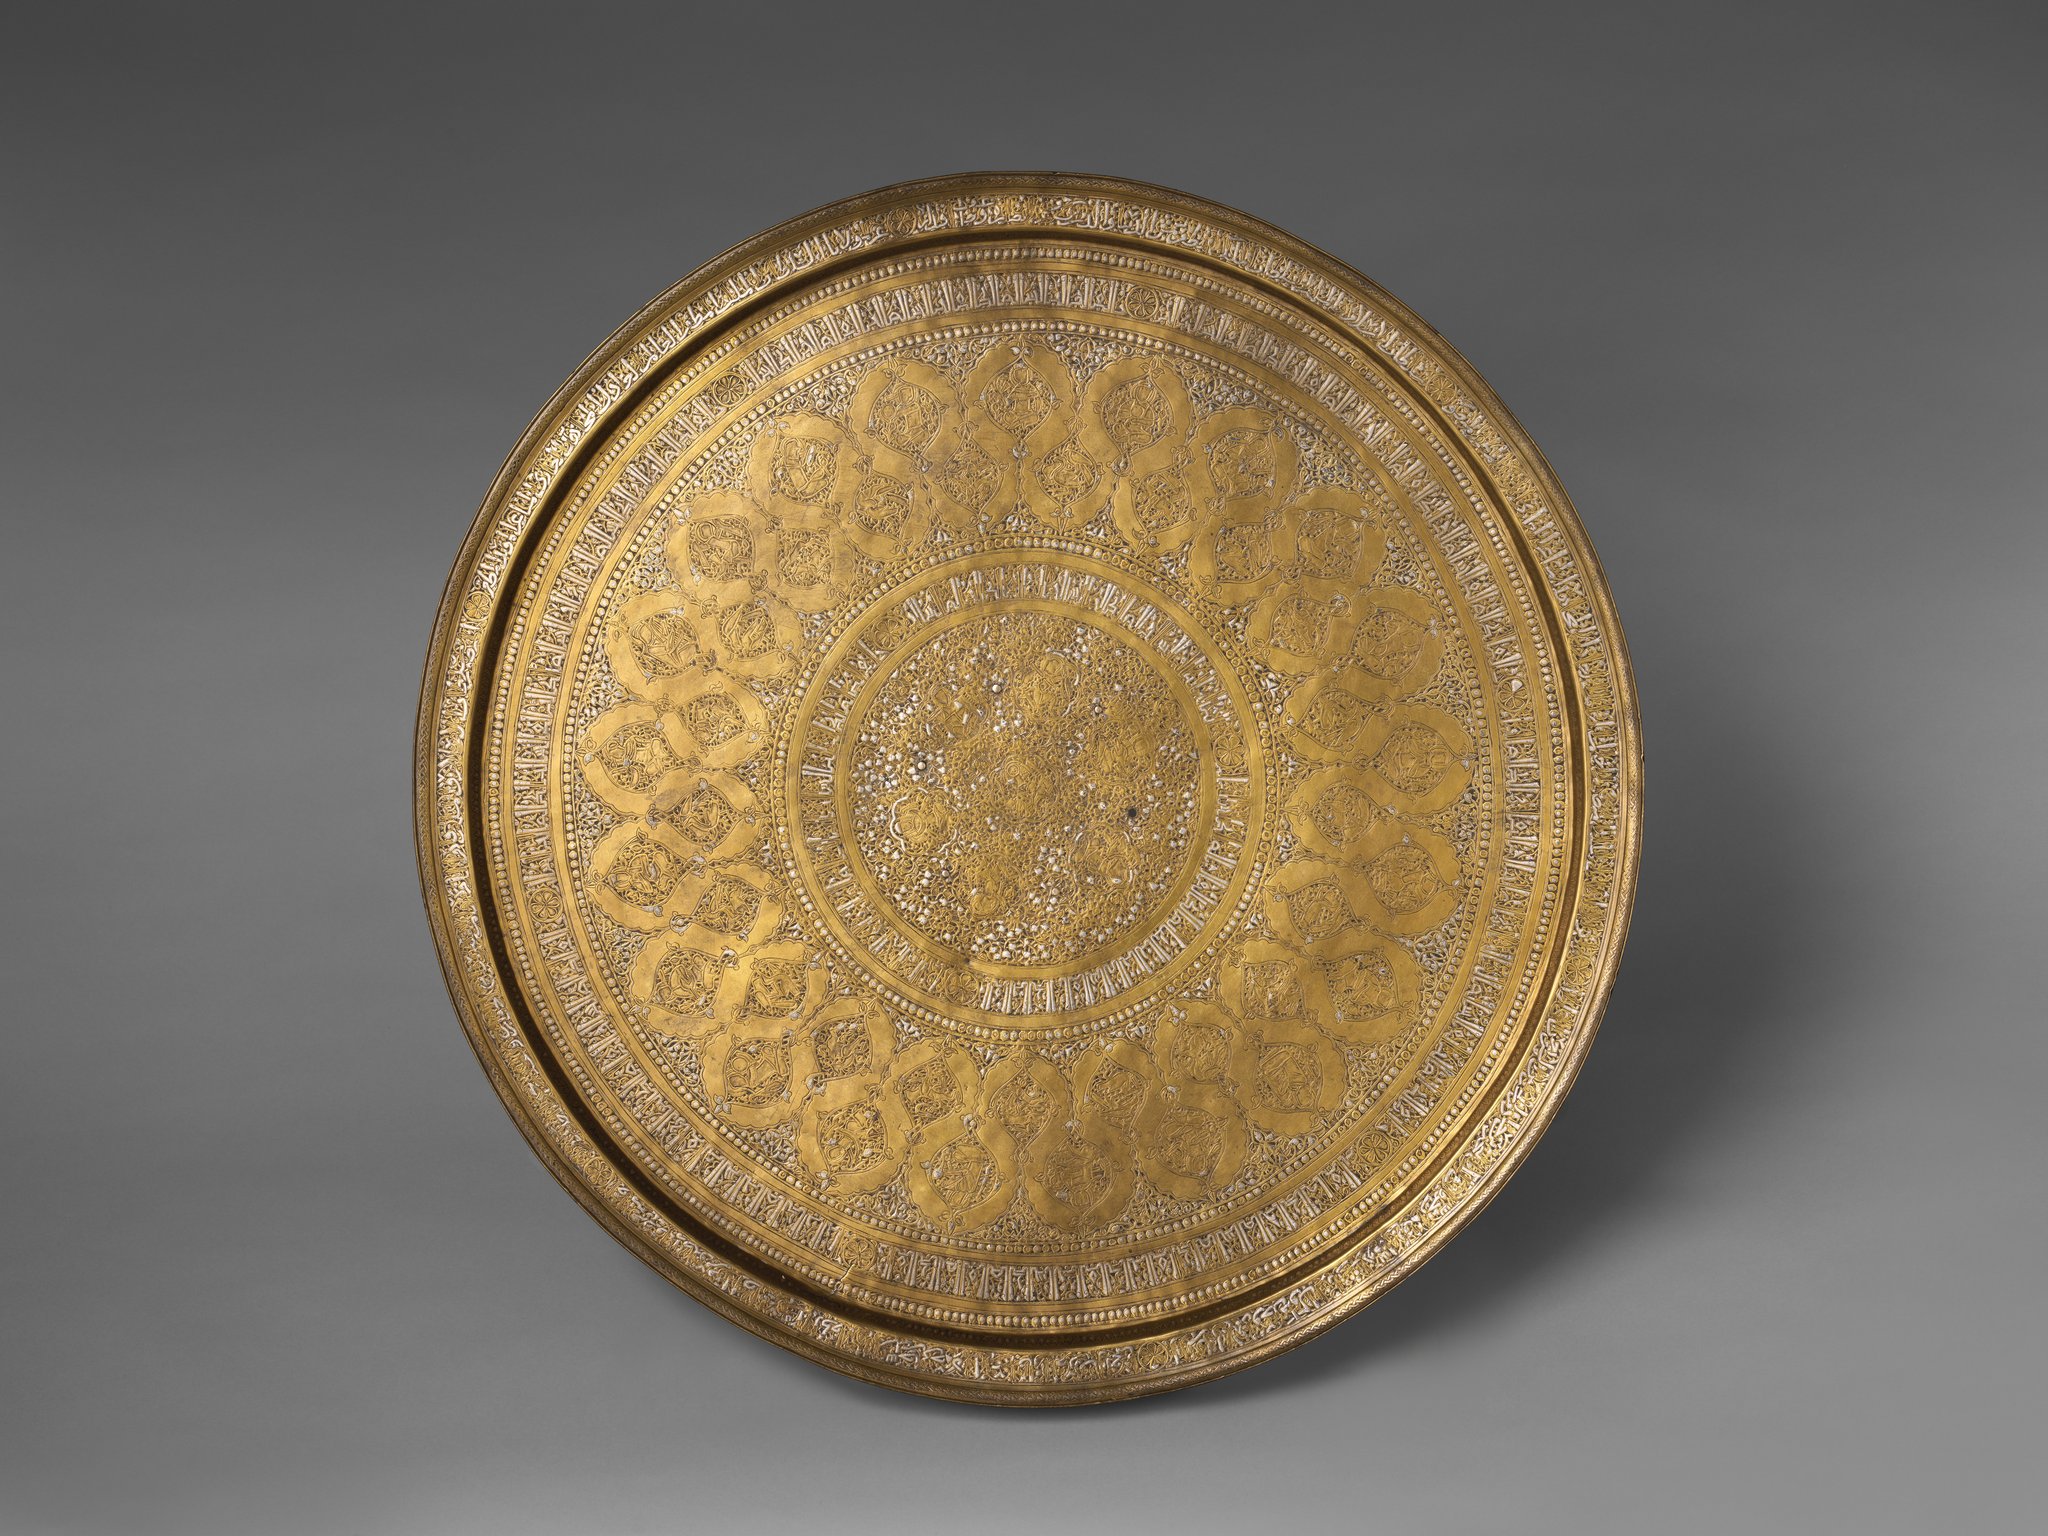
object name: tray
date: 1250-1300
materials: brass, silver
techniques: inlay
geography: egypt or syria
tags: arabic